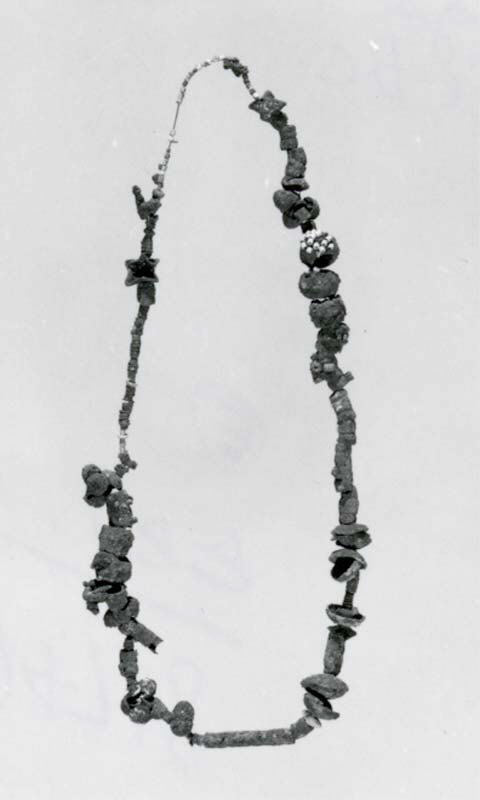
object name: necklace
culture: iranian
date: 900-801 BCE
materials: bone, bronze, stone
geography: iran